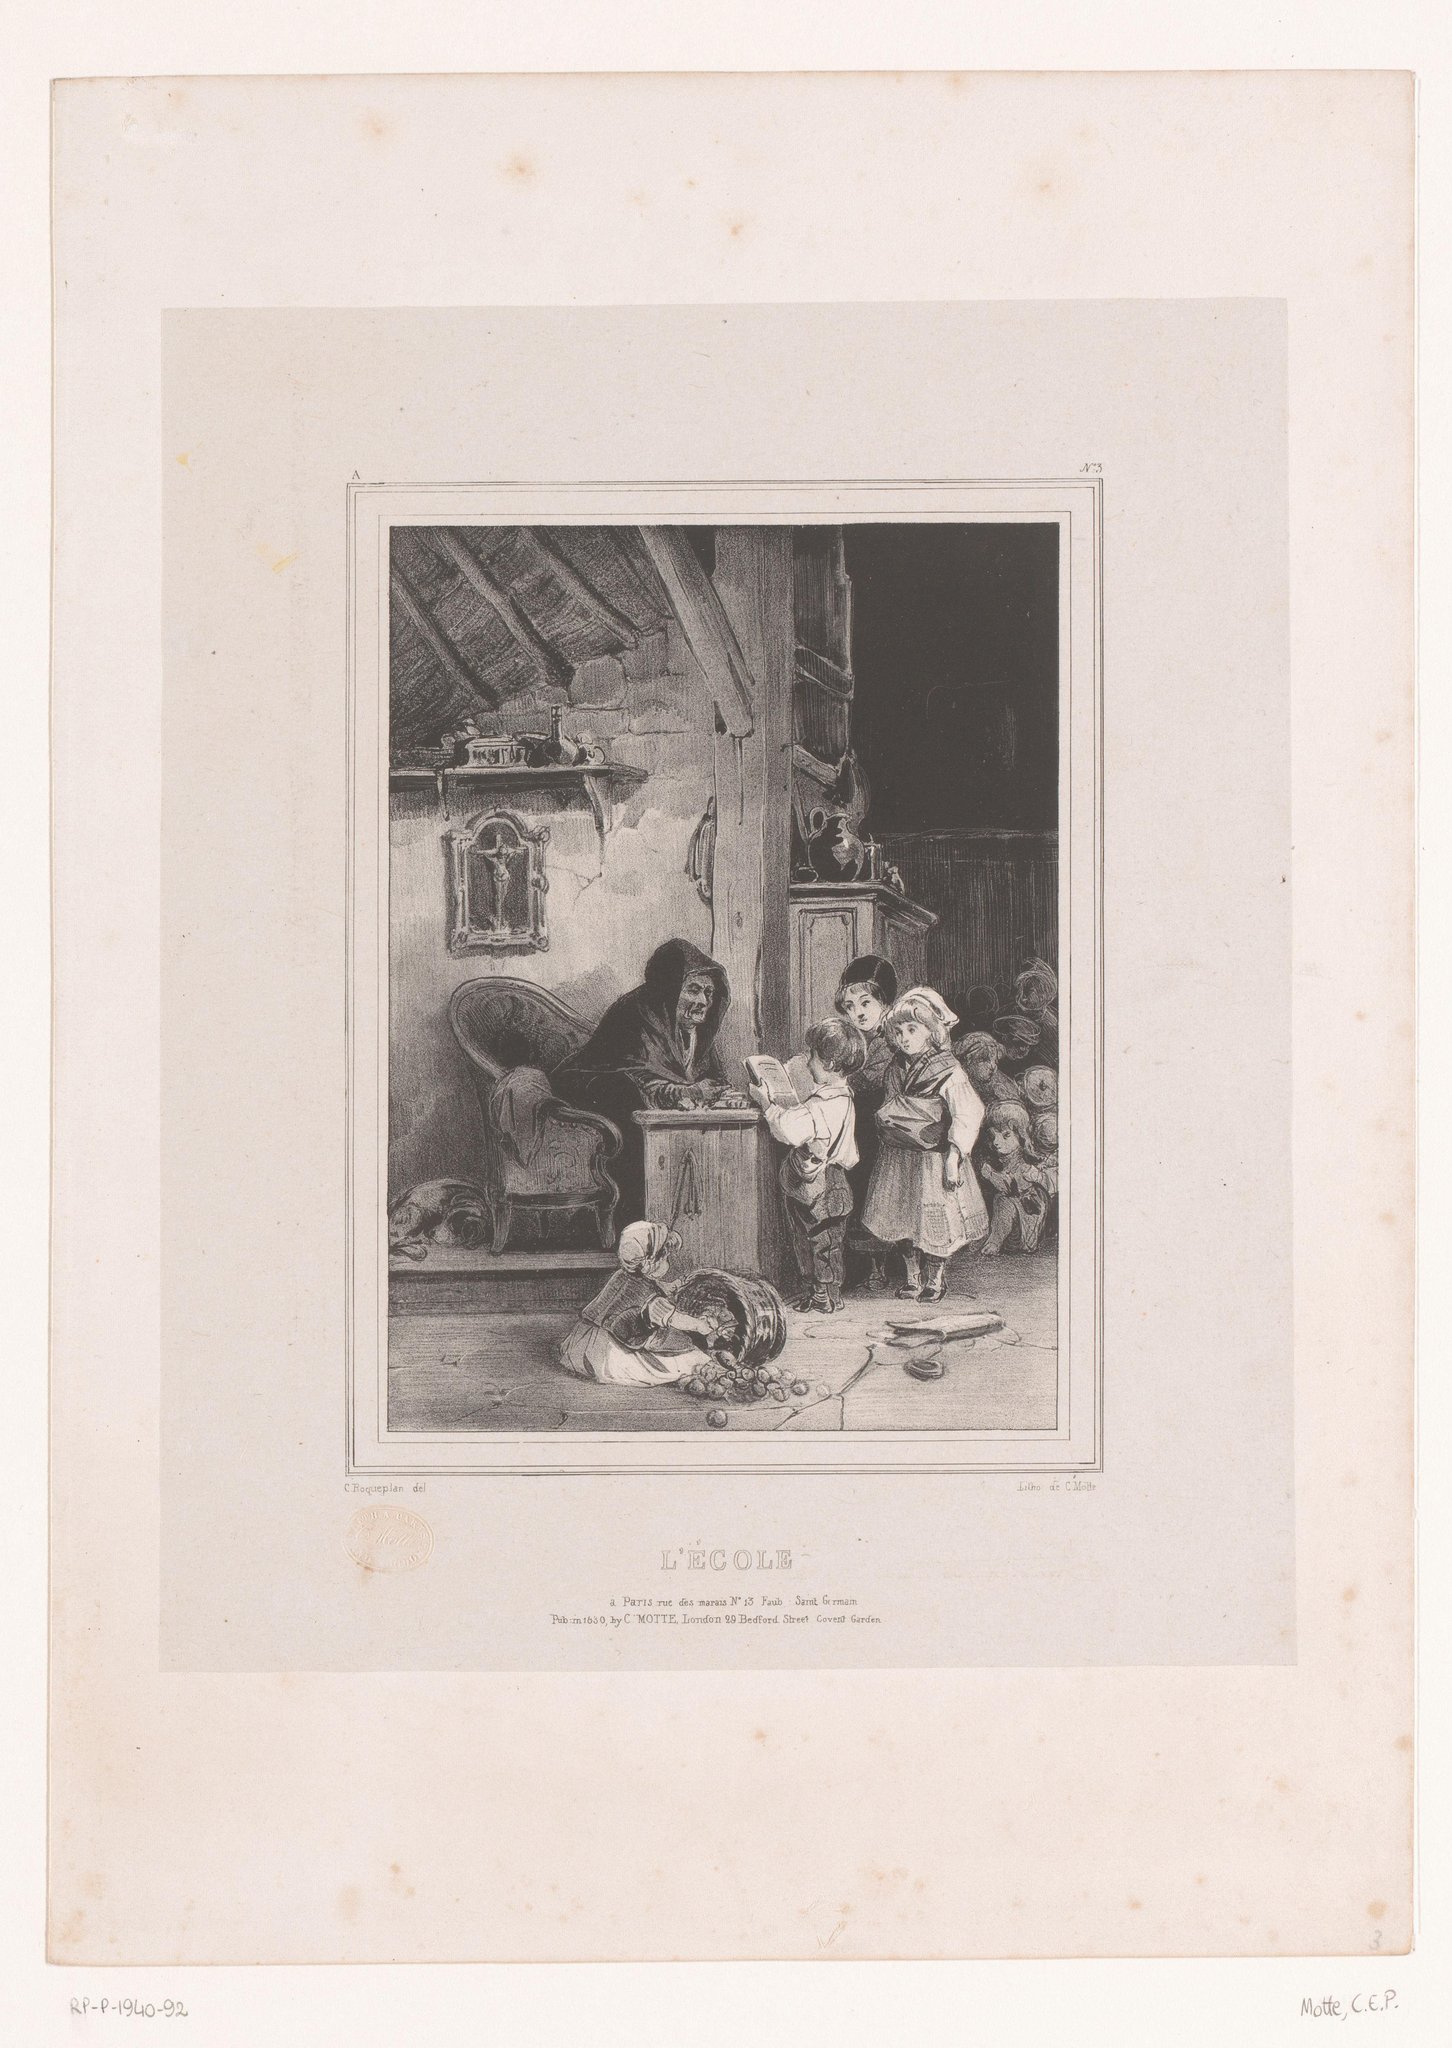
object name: print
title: L'école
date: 1831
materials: paper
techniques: lithograph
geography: paris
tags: teacher and pupil, playing toddler; child amusing itself, elementary school; class, form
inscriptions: check stamp: Lugt 1828b, collector's mark: Lugt 2166, collector's mark: Lugt 2760